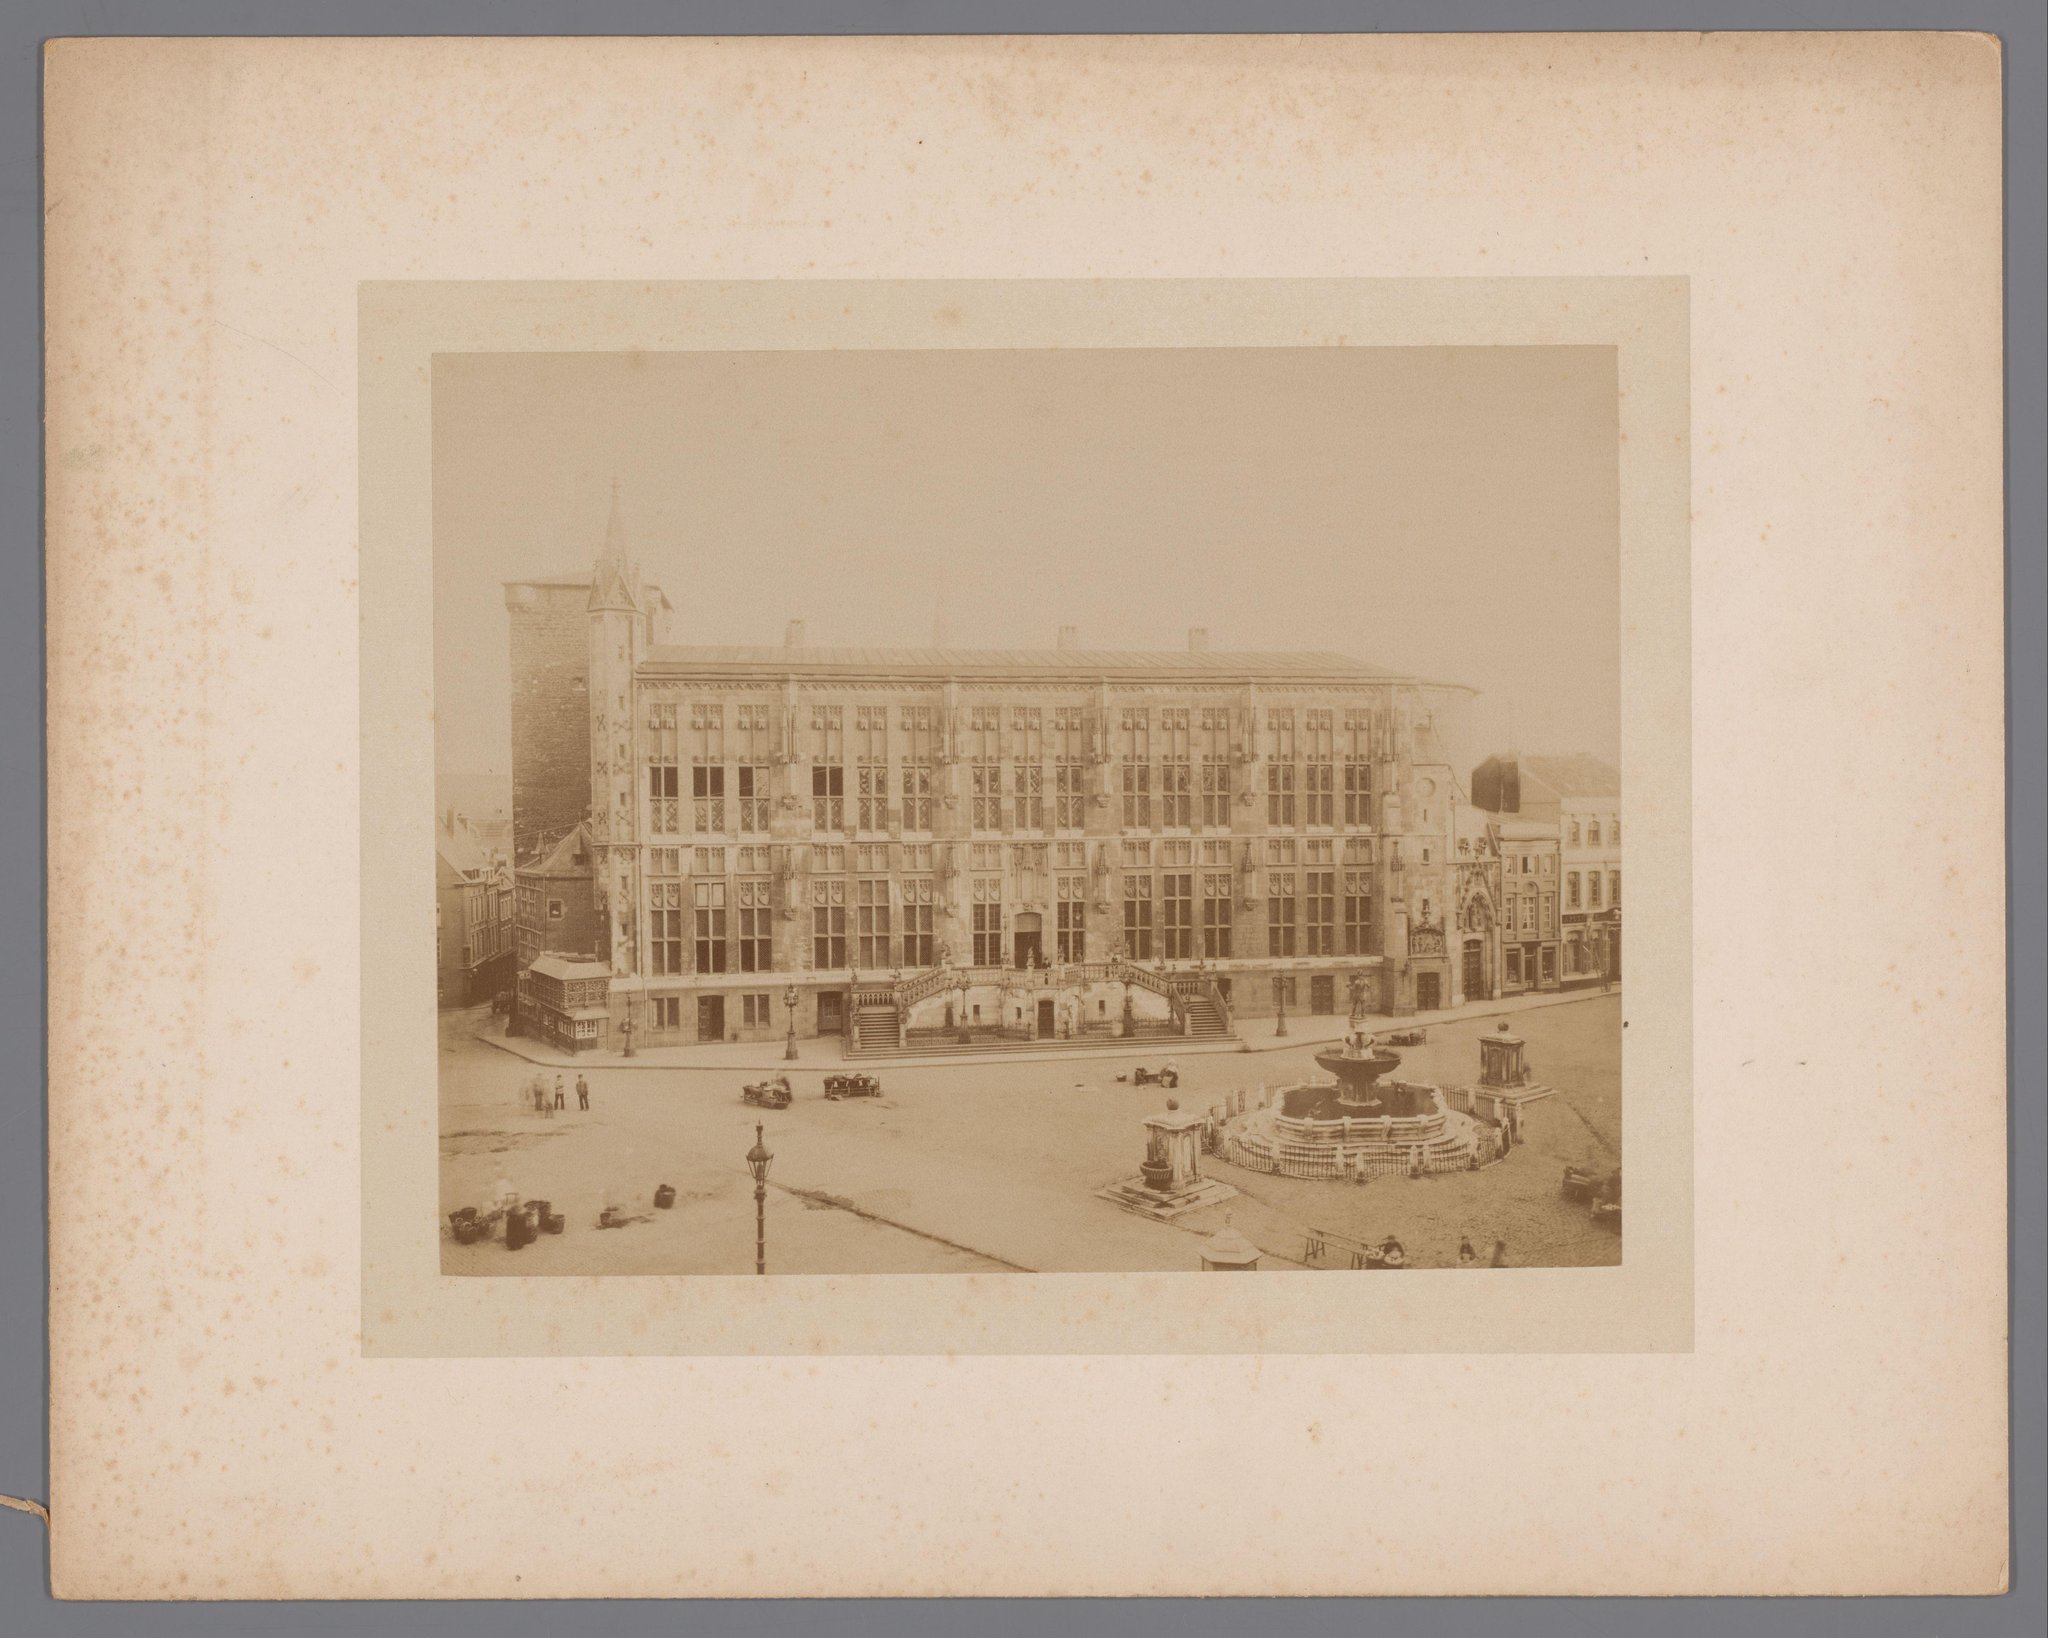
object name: photograph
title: "Stadhuis van Aken na de brand", Duitsland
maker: Anonymous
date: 1883-1910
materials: cardboard, paper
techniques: albumen print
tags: aken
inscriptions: number: ‘19 (in zelfde inkt/handschrift als opschrift verso) met daaroverheen nummer: 38 geschreven in potlood’, inscription: ‘Stadhuis v. Aken na den brand’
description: "Stadhuis van Aken na de brand", Duitsland.